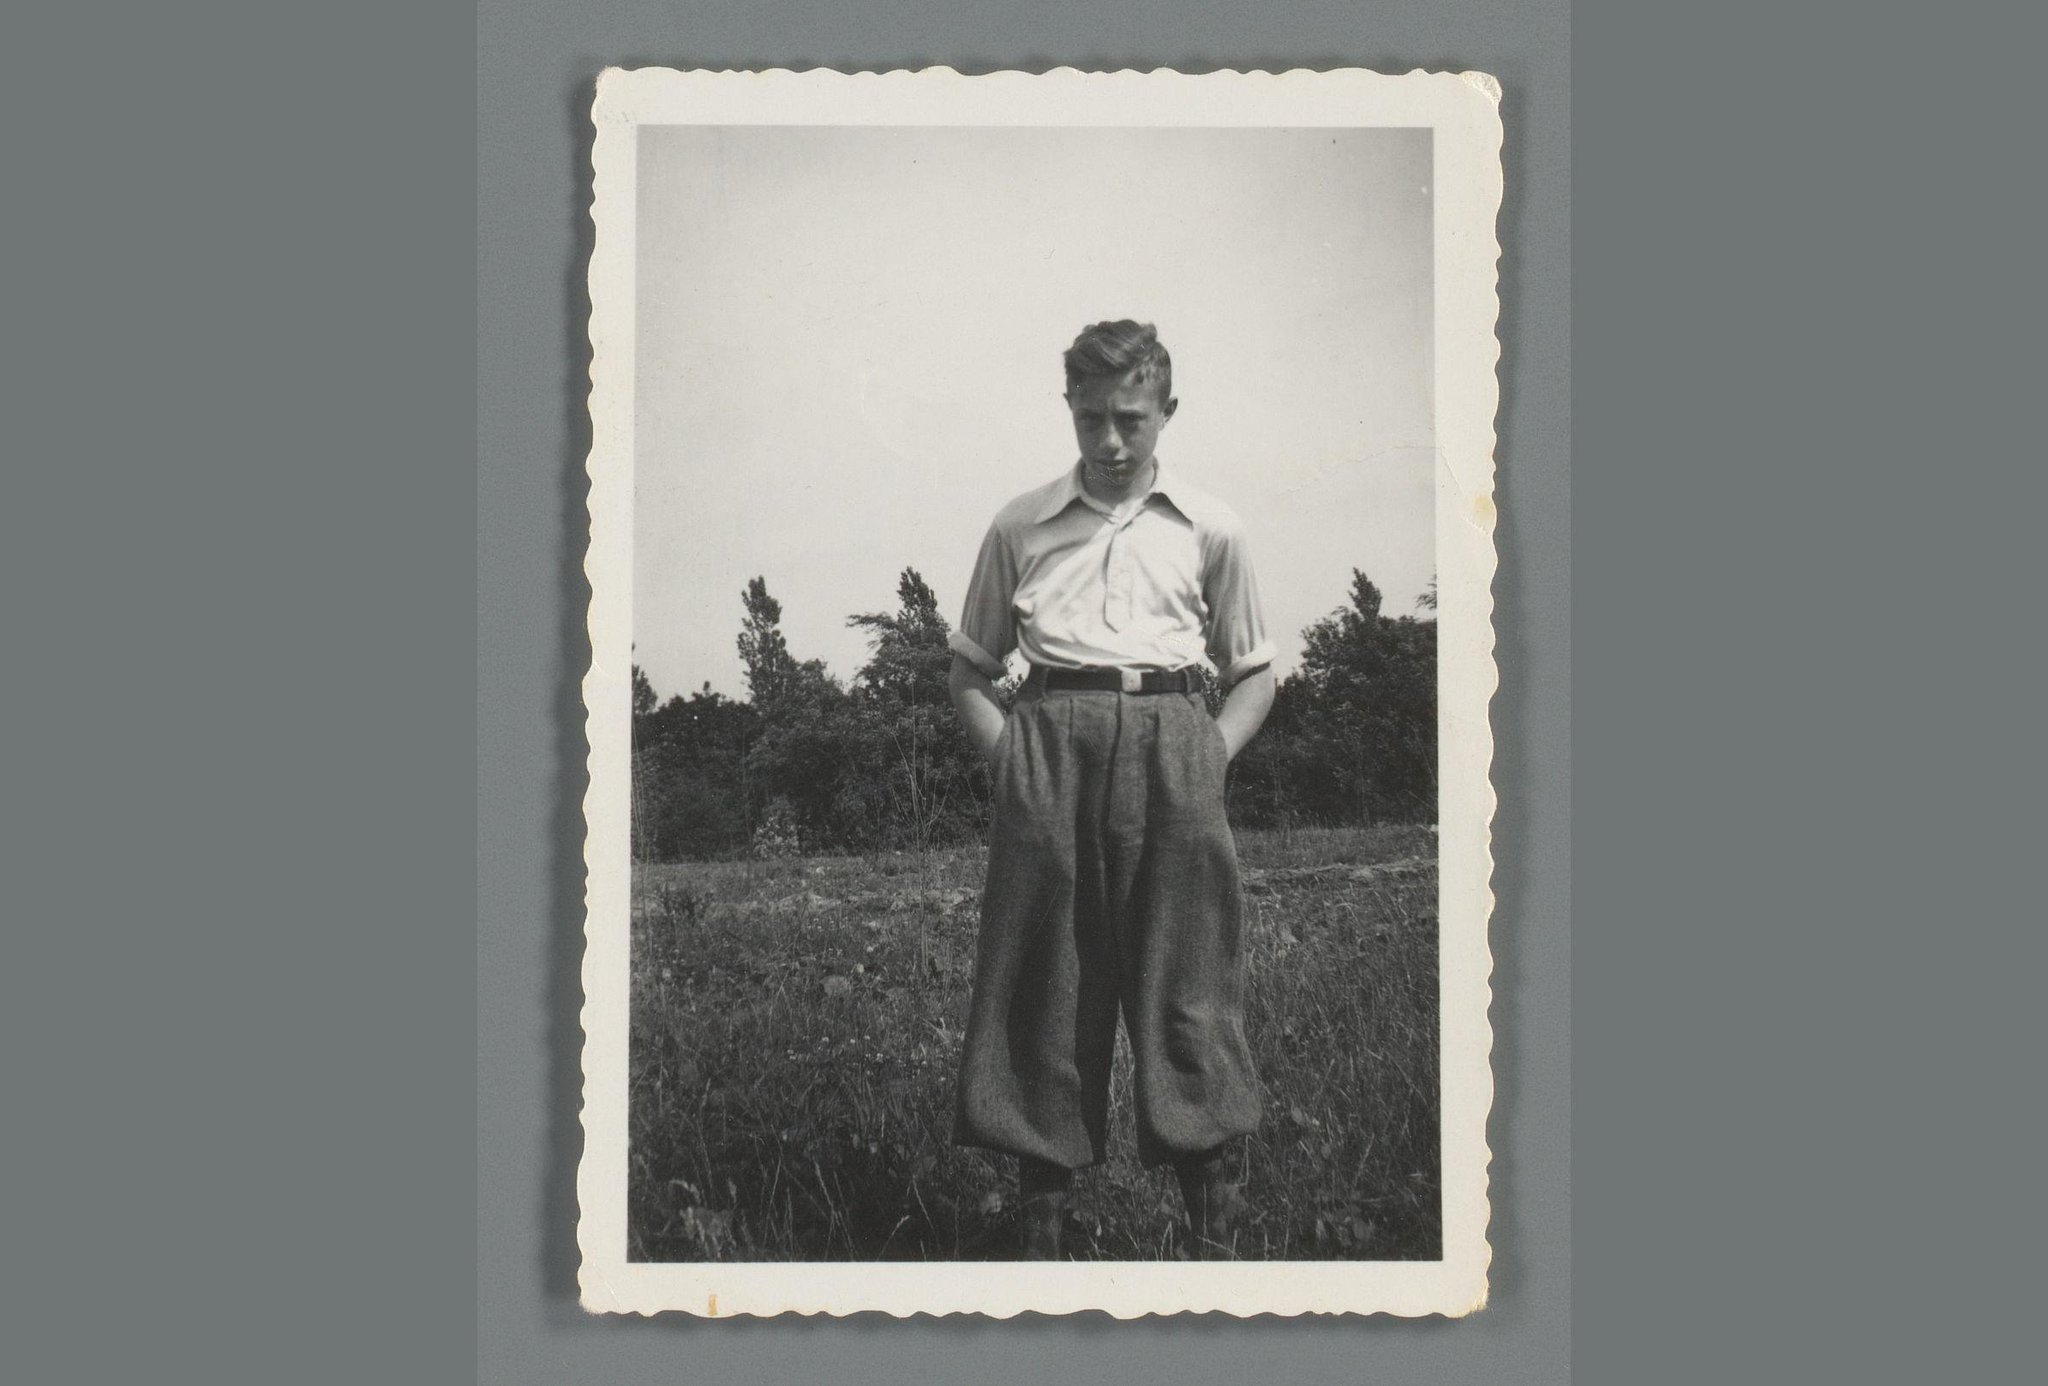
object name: photograph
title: Portret van een onbekende jongen in een veld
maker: Anonymous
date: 1920-1940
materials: paper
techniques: gelatin silver print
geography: schiedam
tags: historical persons not known by name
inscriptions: stamp: ‘Foto-v.d. Arend/ Schiedam/ A4311’